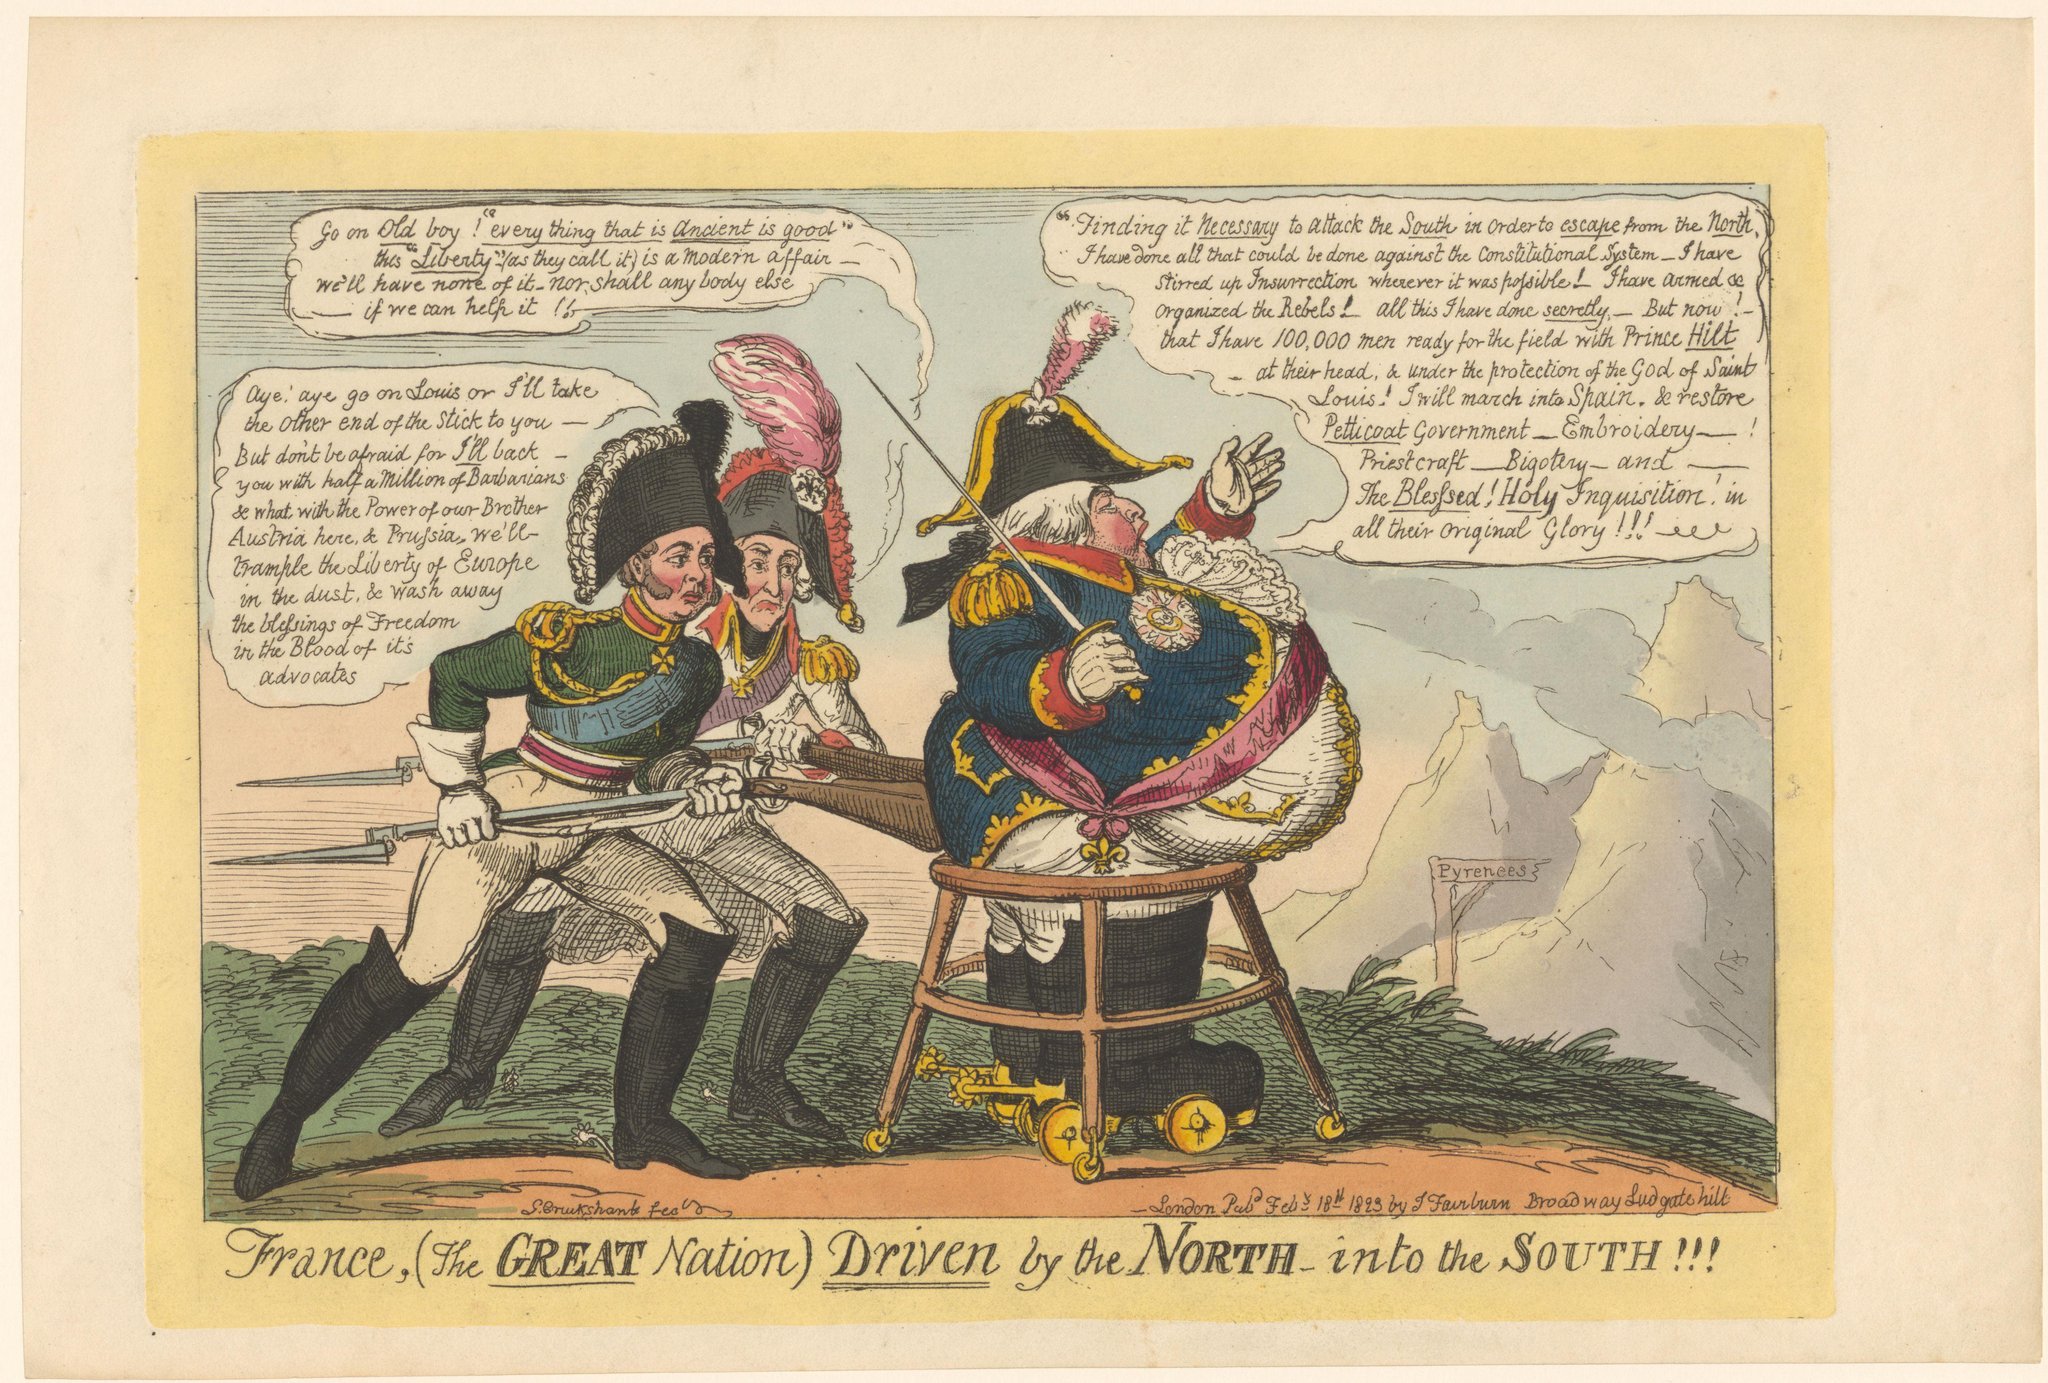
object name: cartoon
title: Lodewijk XVIII wordt op rolschaatsen door Alexander I van Rusland en keizer Frans II richting de Pyreneeën geduwd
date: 1802-1823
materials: paper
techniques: etching, hand coloring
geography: london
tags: paris, lodewijk xviii (koning van frankrijk), vienna, frans ii (rooms-duits keizer), alexander i (tsaar van rusland), roller-skating, roller-skates, political caricatures and satires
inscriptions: collector's mark: Lugt 2228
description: Spotprent op de Franse invasie van Spanje, 1823.